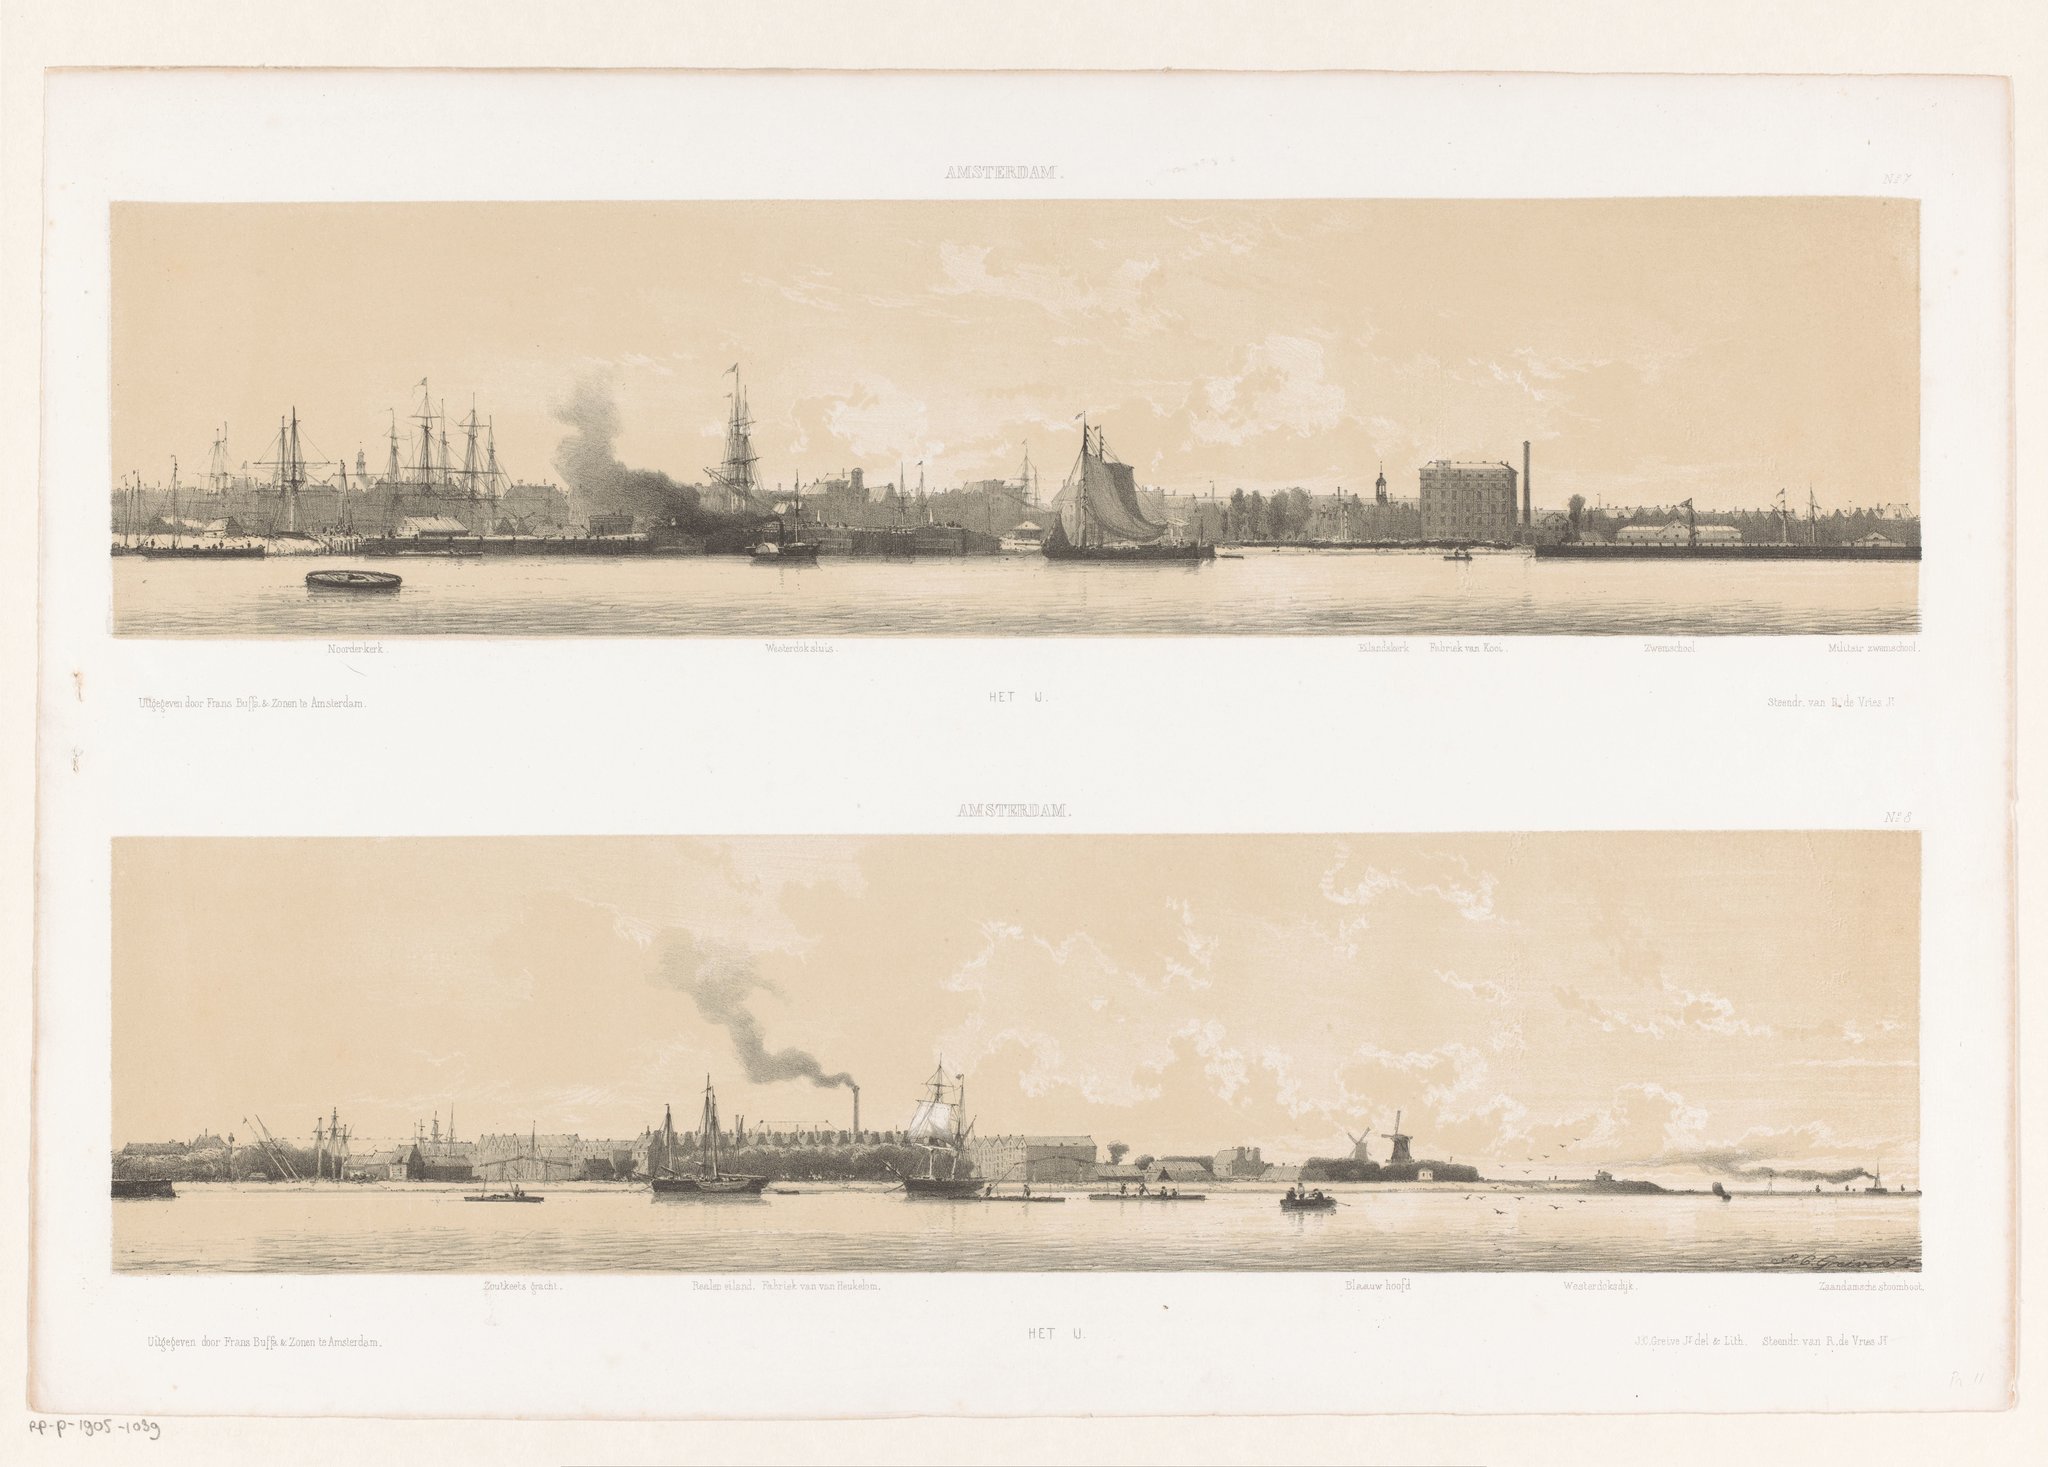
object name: print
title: Profiel van Amsterdam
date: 1860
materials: paper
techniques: tone lithography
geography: amsterdam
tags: prospect of city, town panorama, silhouette of city, amsterdam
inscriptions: collector's mark: Lugt 2228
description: De stad is vanaf het IJ gezien. In het bovenste profiel zijn de Noorderkerk, de Westerdoksluis, de Eilandskerk, de fabriek van Kooi, de zwemschool en het militair zwembad afgebeeld. Het tweede profiel daaronder gaat door met de Zoutkeetsgracht, Realen Eiland, de fabriek van Heukelom, het Blaauw hoofd, Westerdoksdijk en de Zaandamse stoomboot. Beiden profielen zijn rechtsboven genummerd.